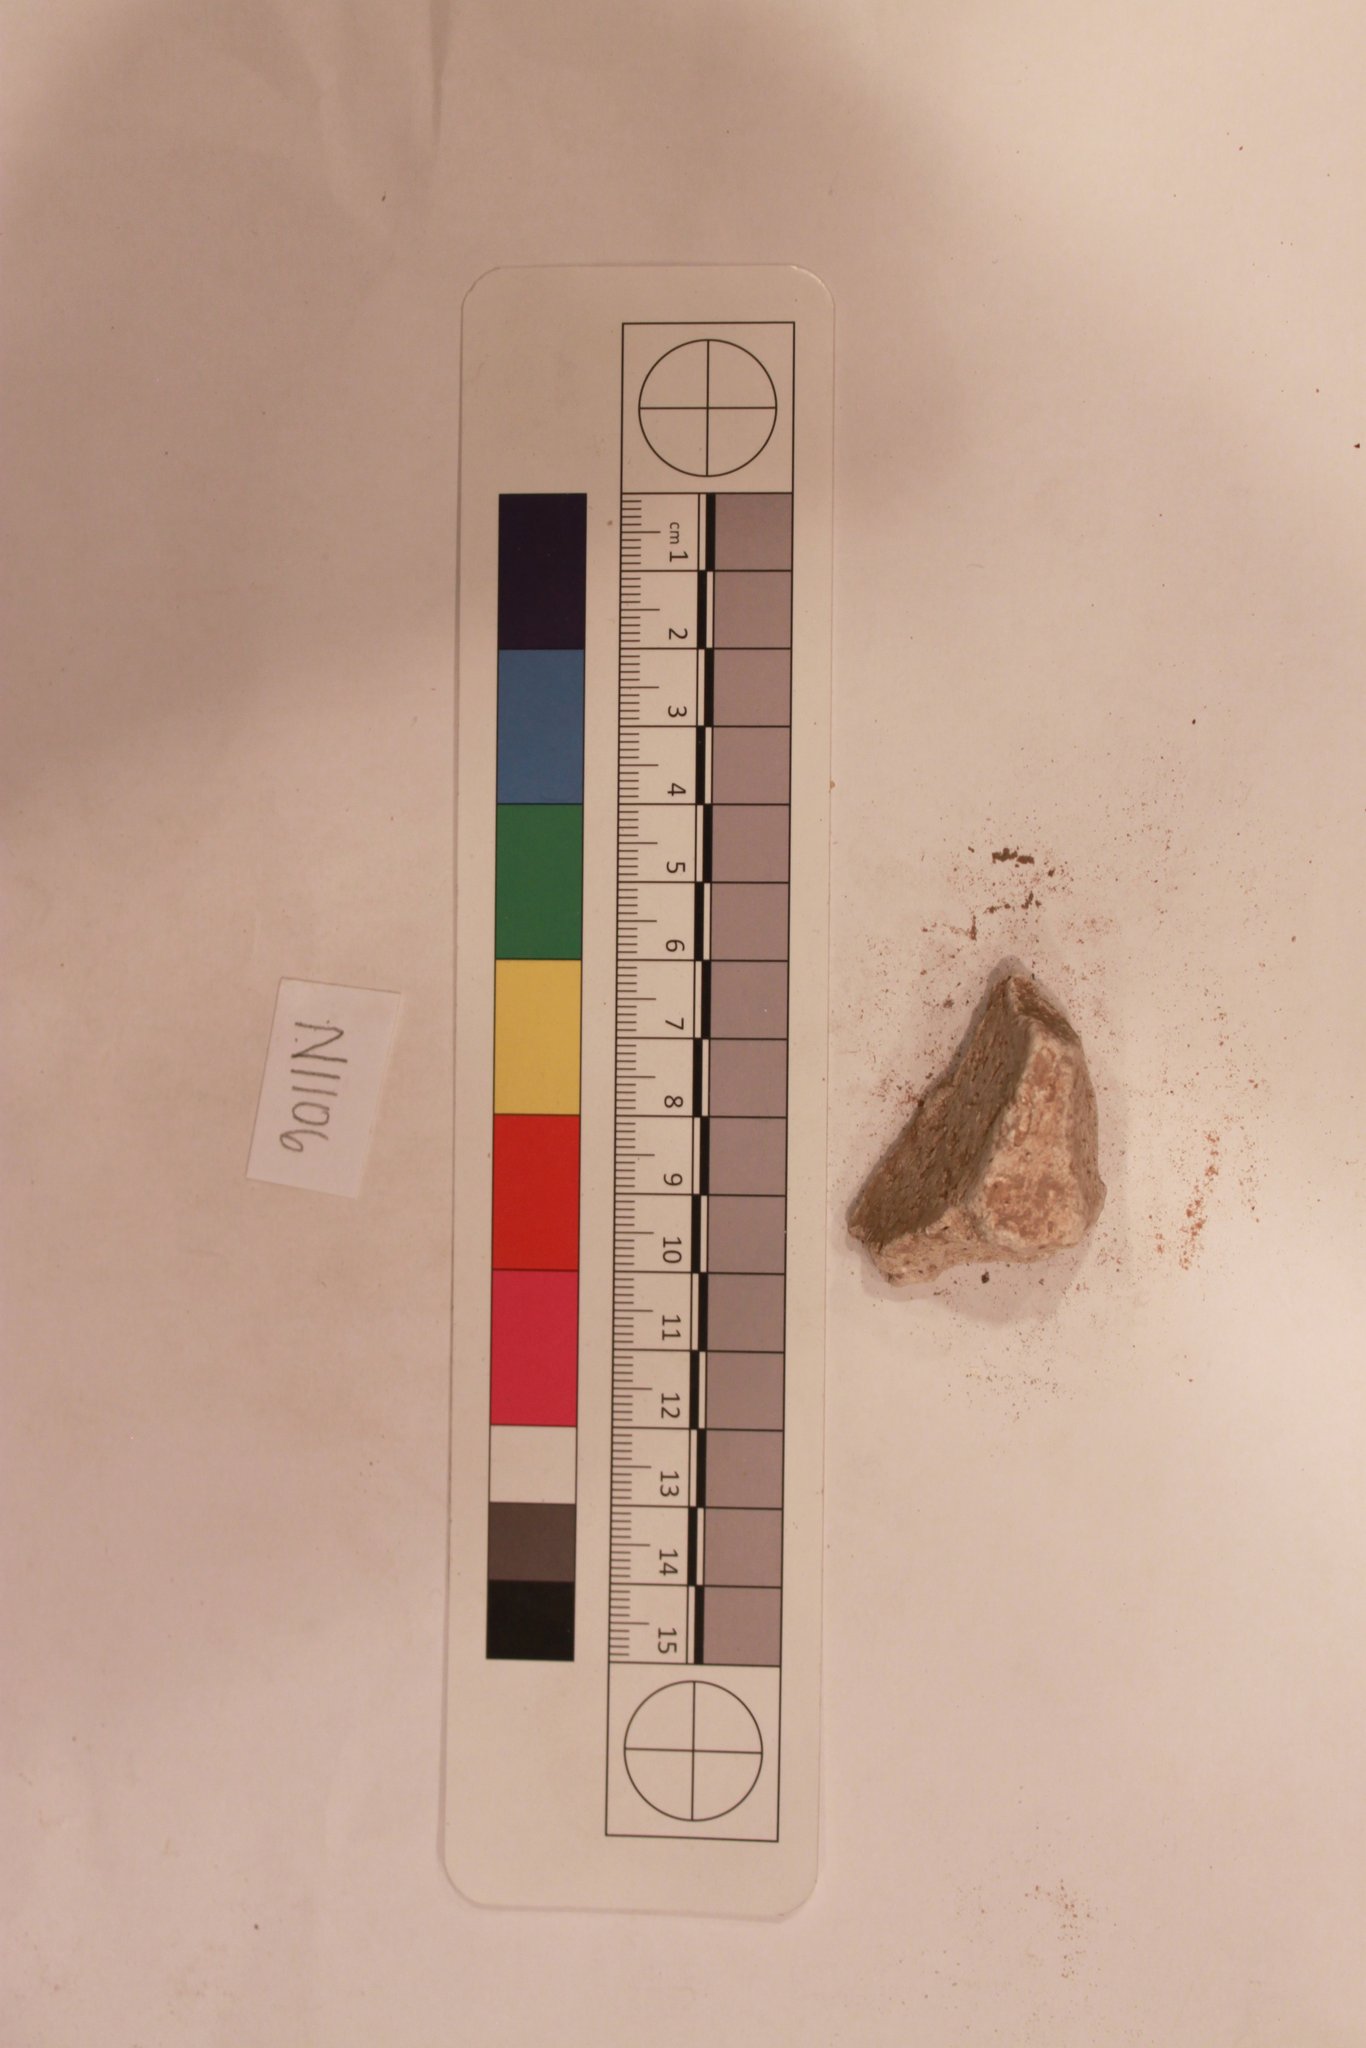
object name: fragment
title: Stucco Fragment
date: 701-1200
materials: plaster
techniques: carving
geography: iran